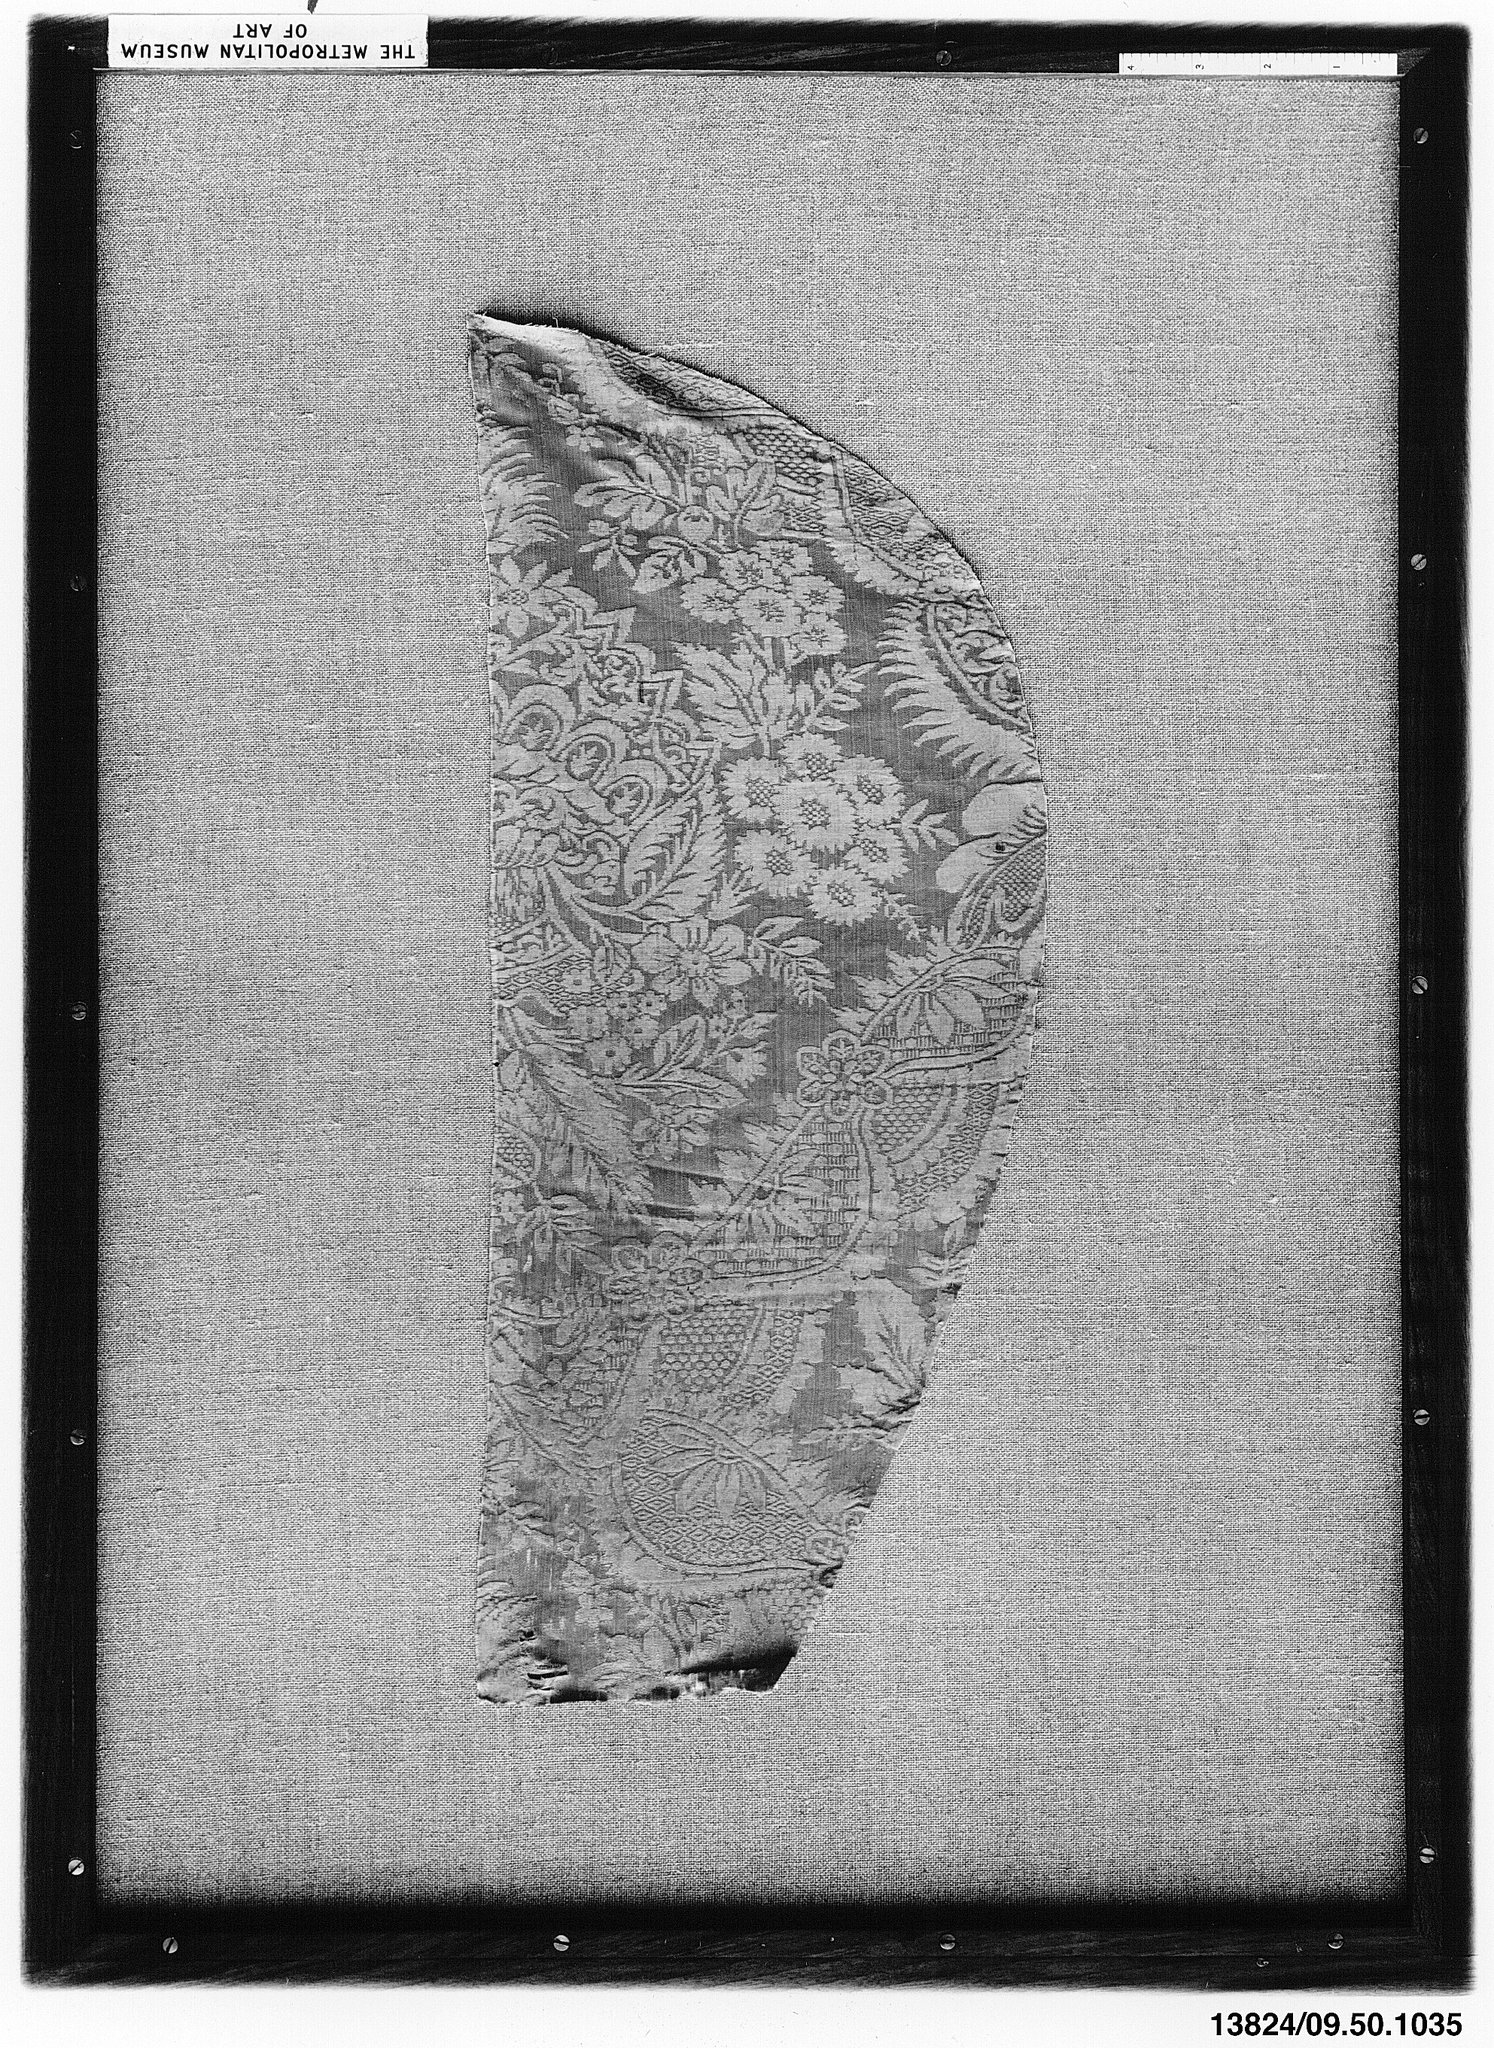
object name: piece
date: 1701-1733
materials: silk